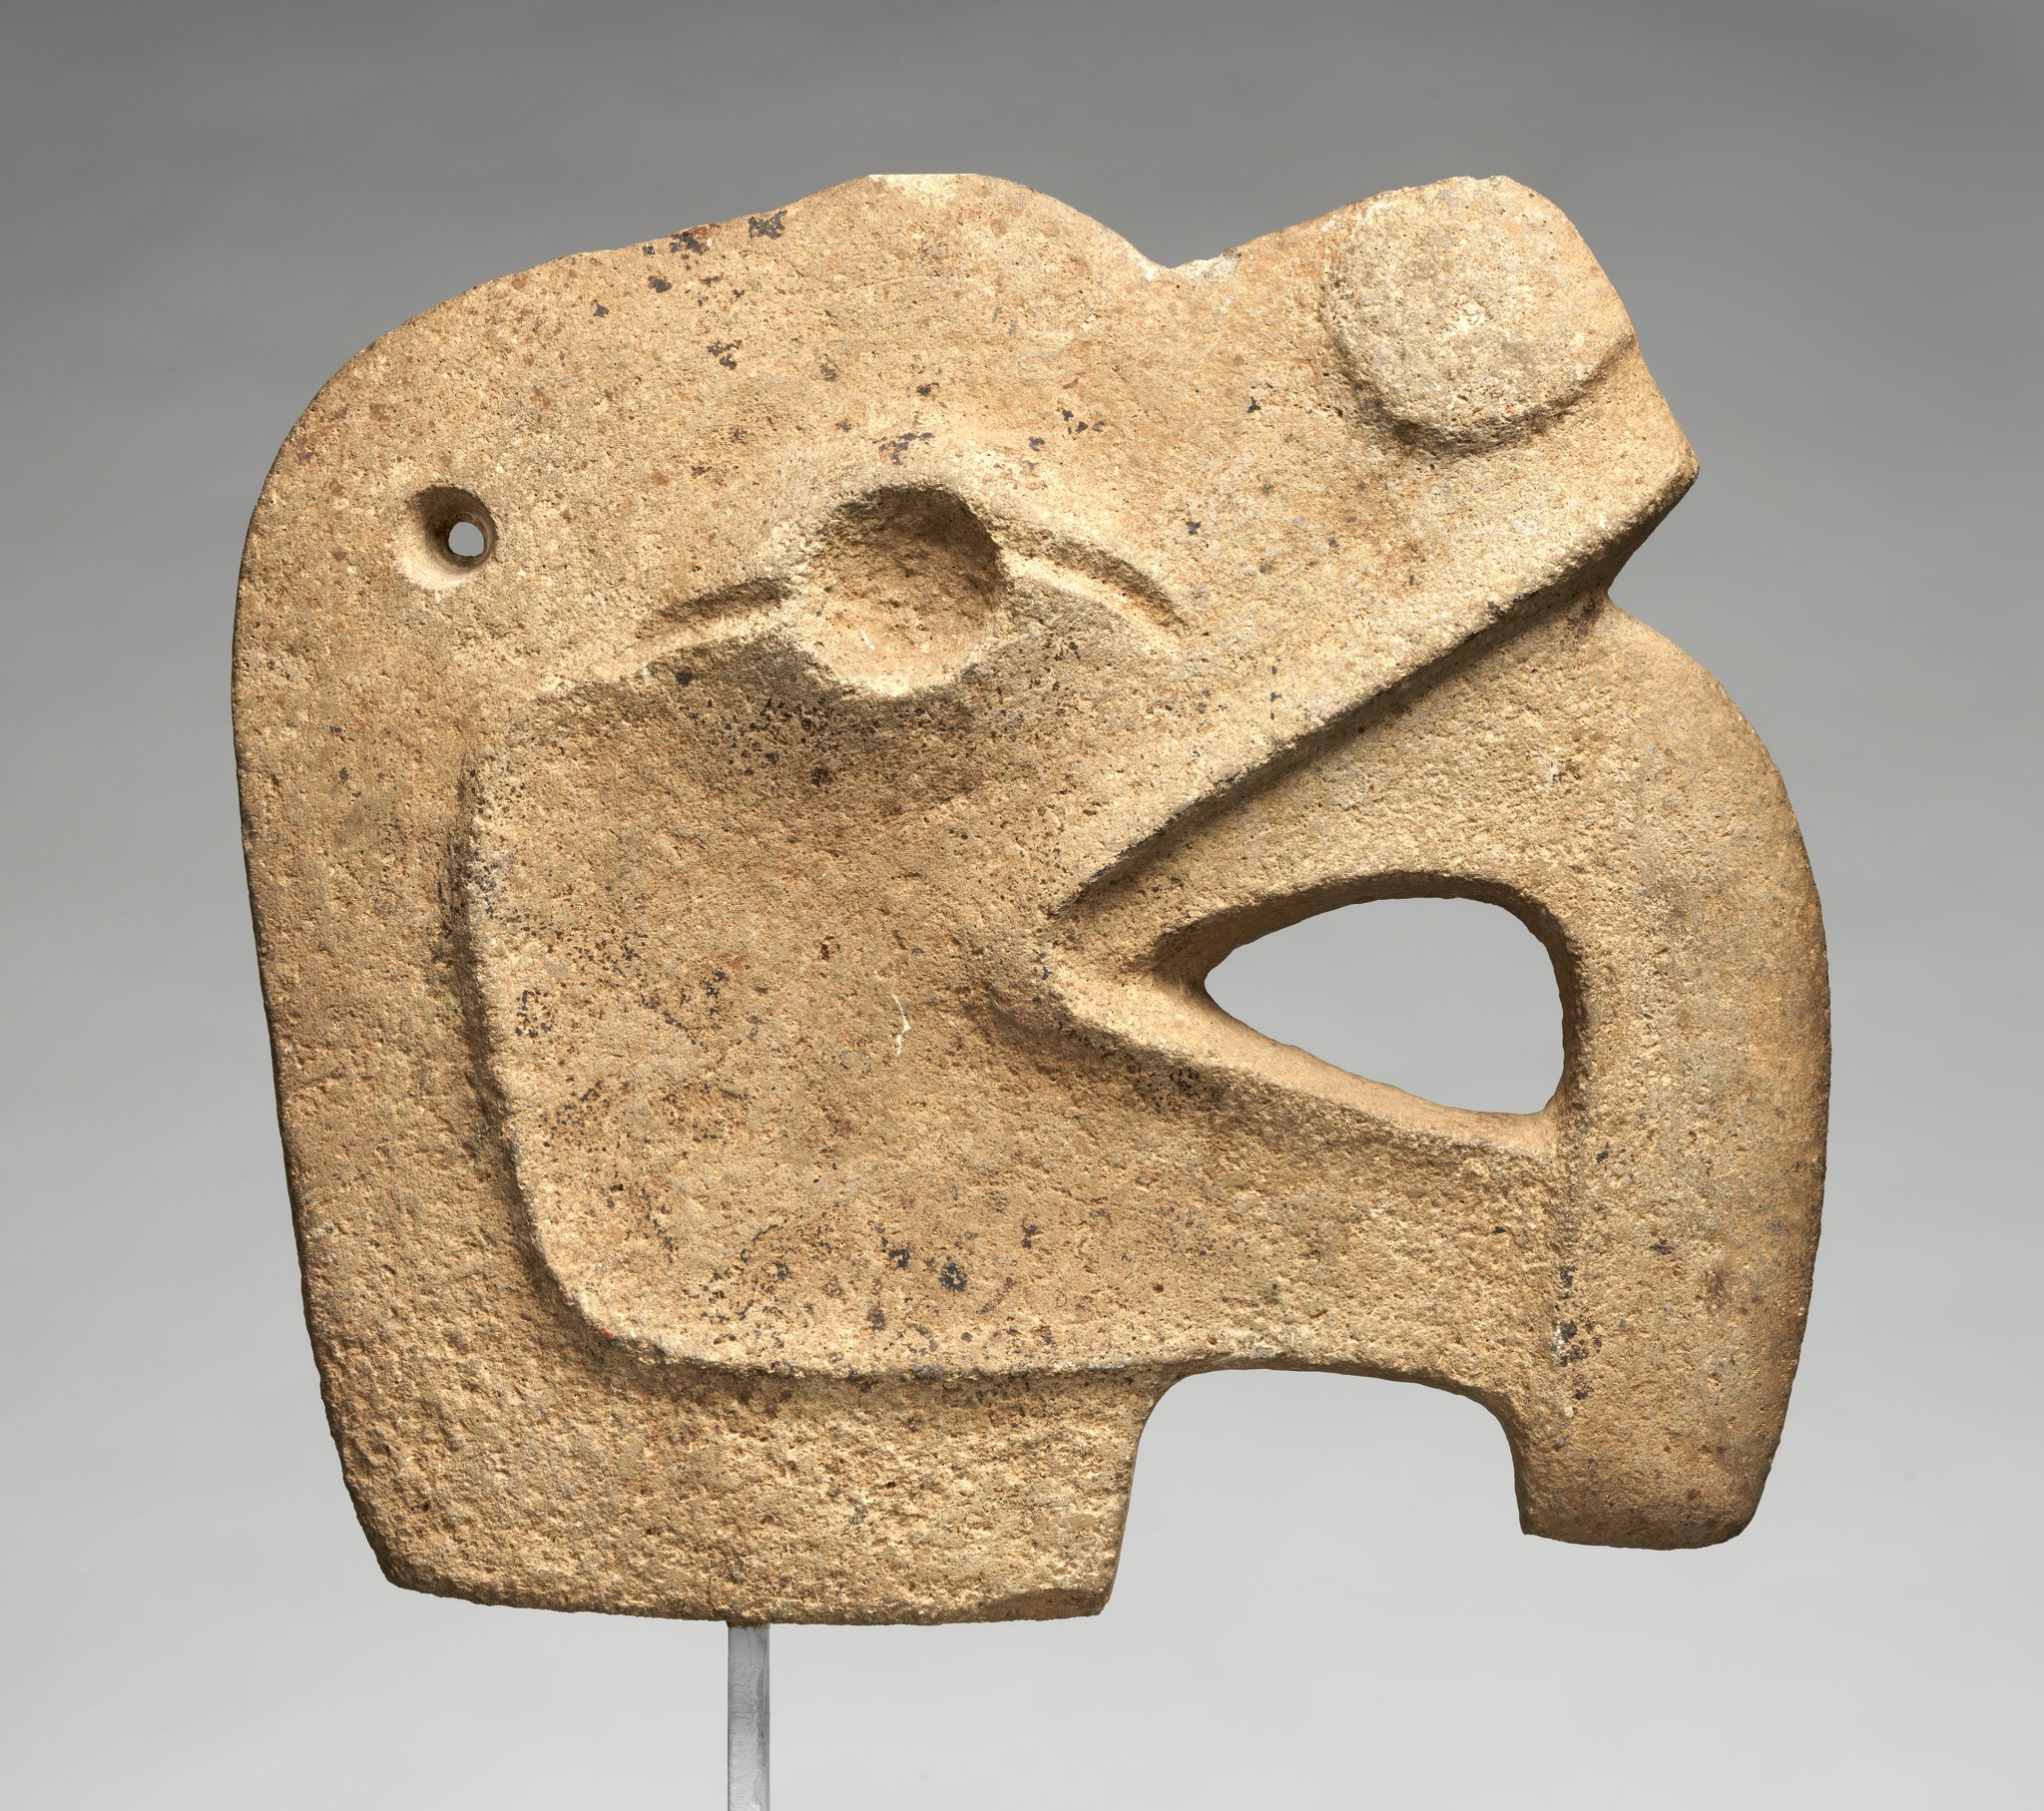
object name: hacha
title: Feline head hacha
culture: maya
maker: southern mesoamerican artist(s)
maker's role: artist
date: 800-1100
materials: stone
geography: guatemala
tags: animals